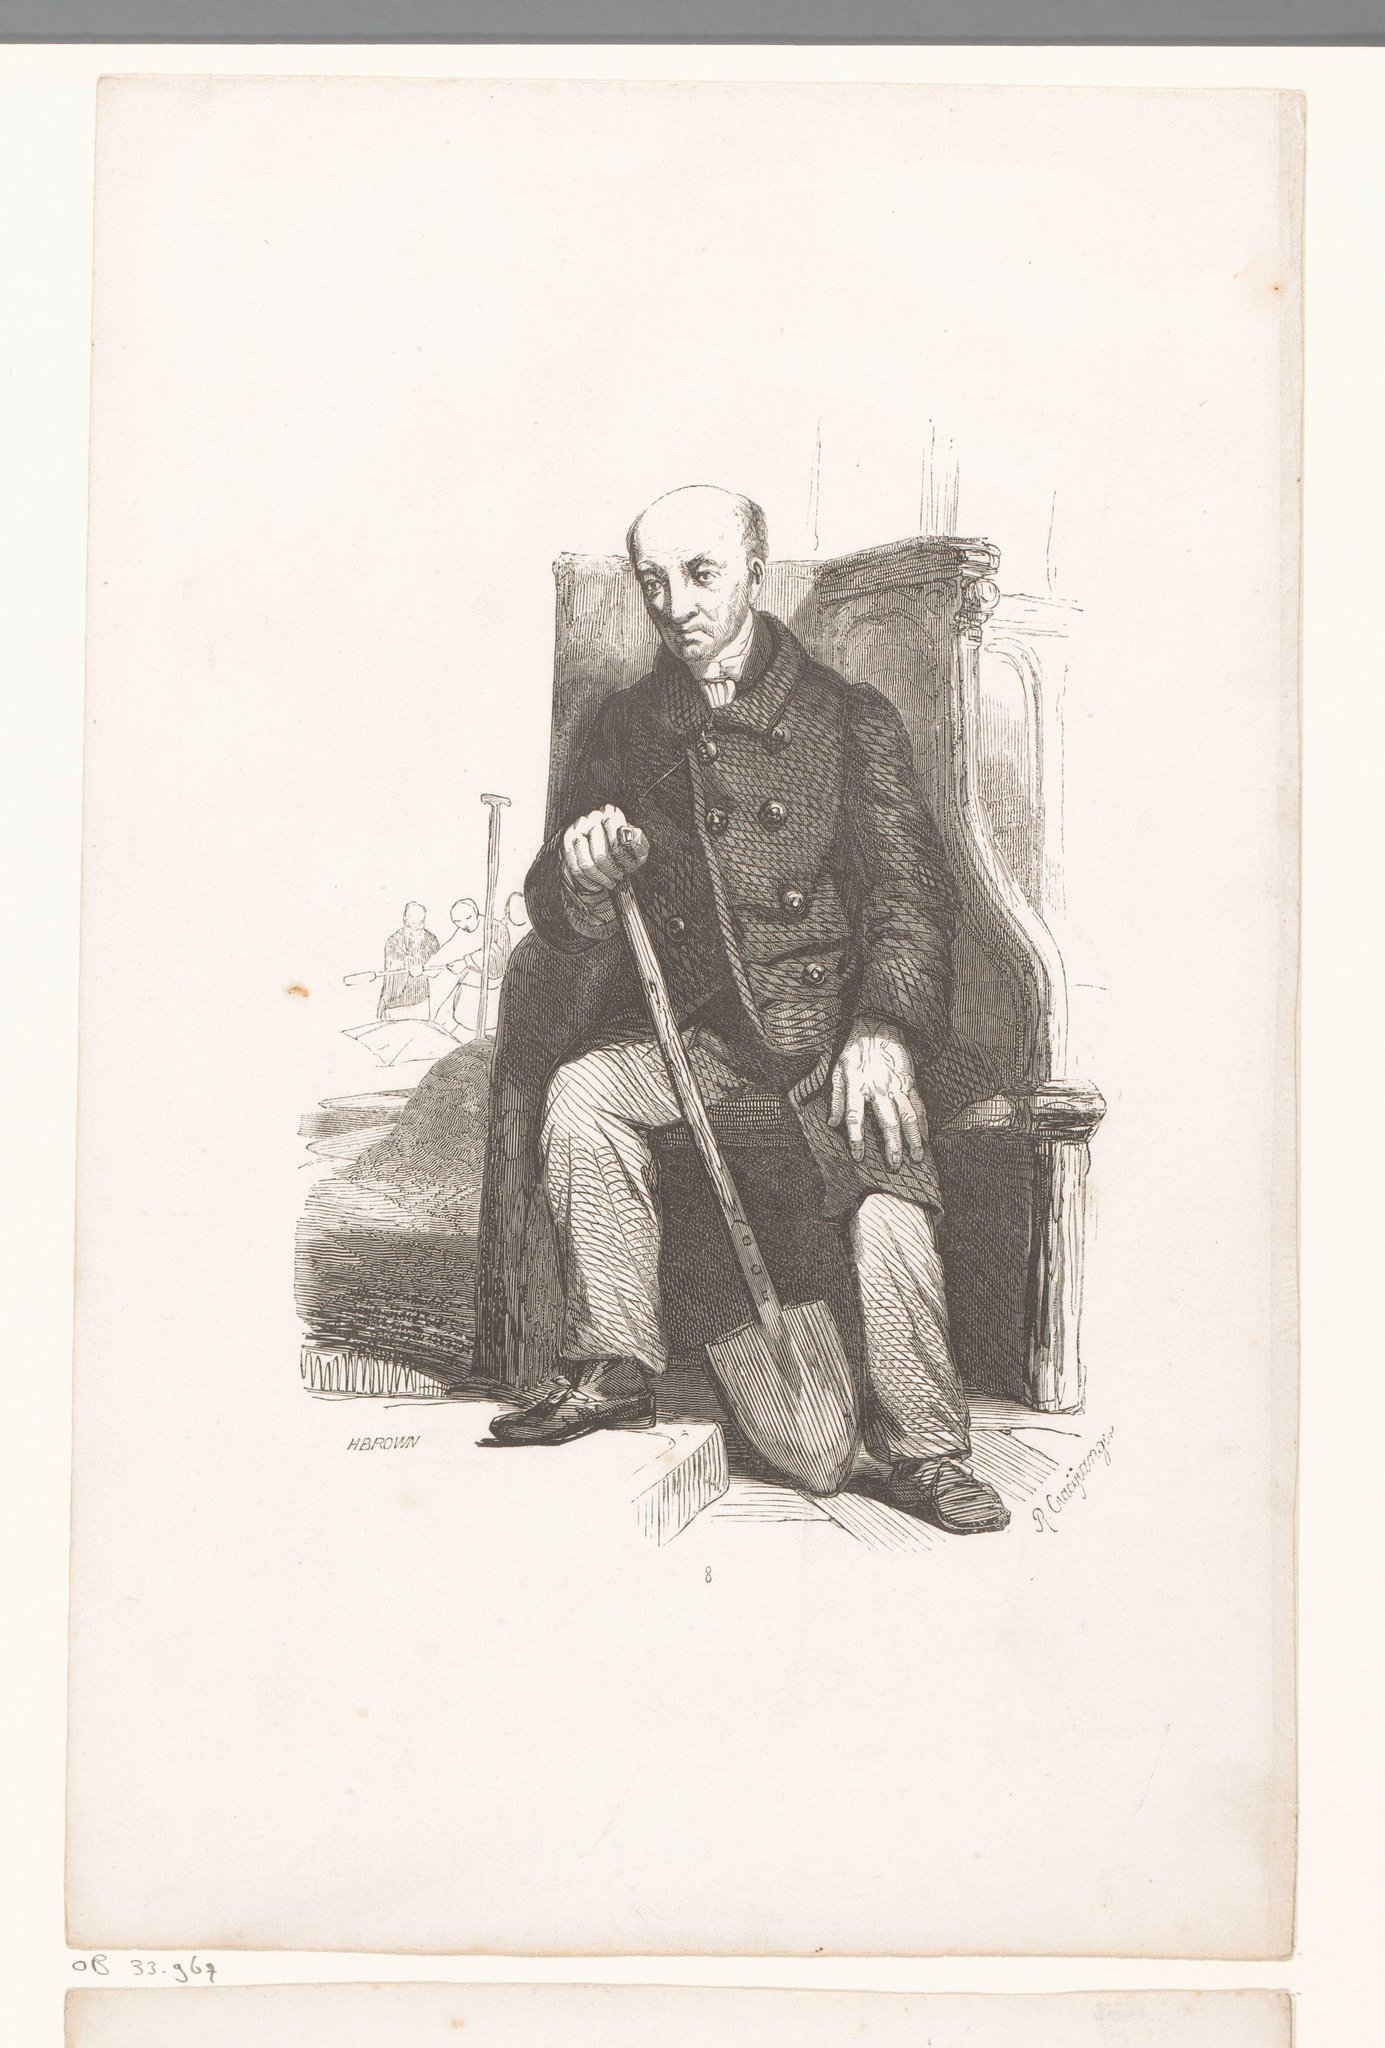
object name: print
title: Grafdelver met schep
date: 1841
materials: paper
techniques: engraving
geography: the hague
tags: adult man, grave digger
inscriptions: collector's mark: Lugt 2228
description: Prent uit: Brown, Henry. De Nederlanden: karakterschetsen, kleederdragten, houding en voorkomen van verschillende standen. Den Haag: Nederlandsche Maatschappij van Schoone Kunsten, 1841.